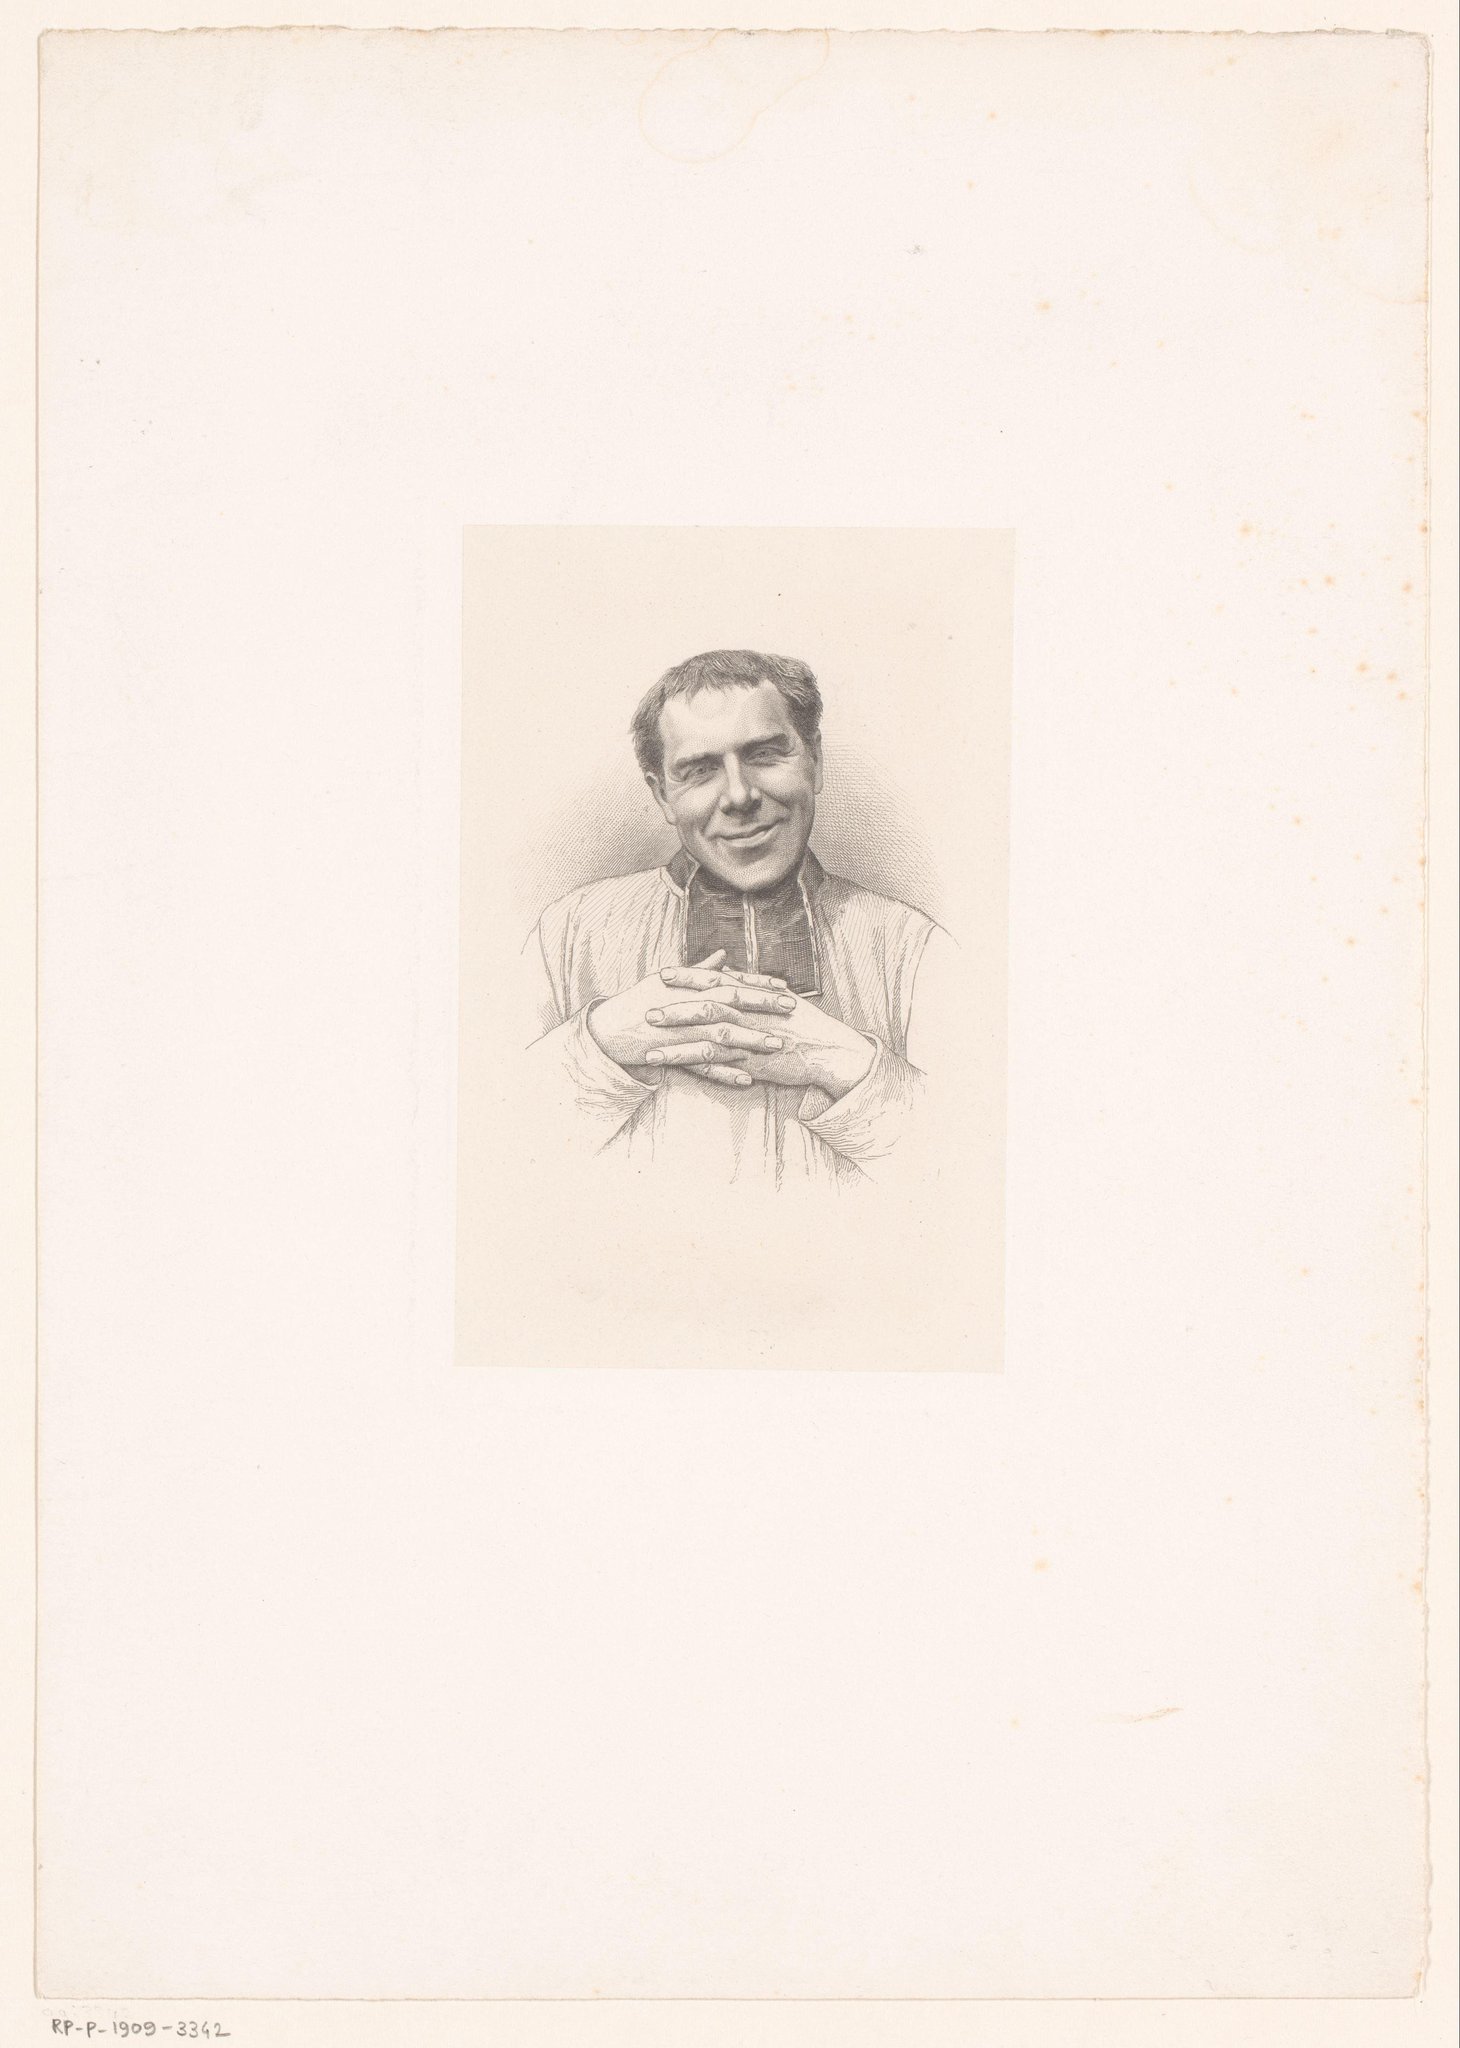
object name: print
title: Portret van Ernest Alexandre Honoré Coquelin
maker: alphonse descaves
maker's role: print maker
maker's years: 1830-1890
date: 1840-1890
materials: paper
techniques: engraving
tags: historical persons, portrait of actor, actress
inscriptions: collector's mark: Lugt 2228